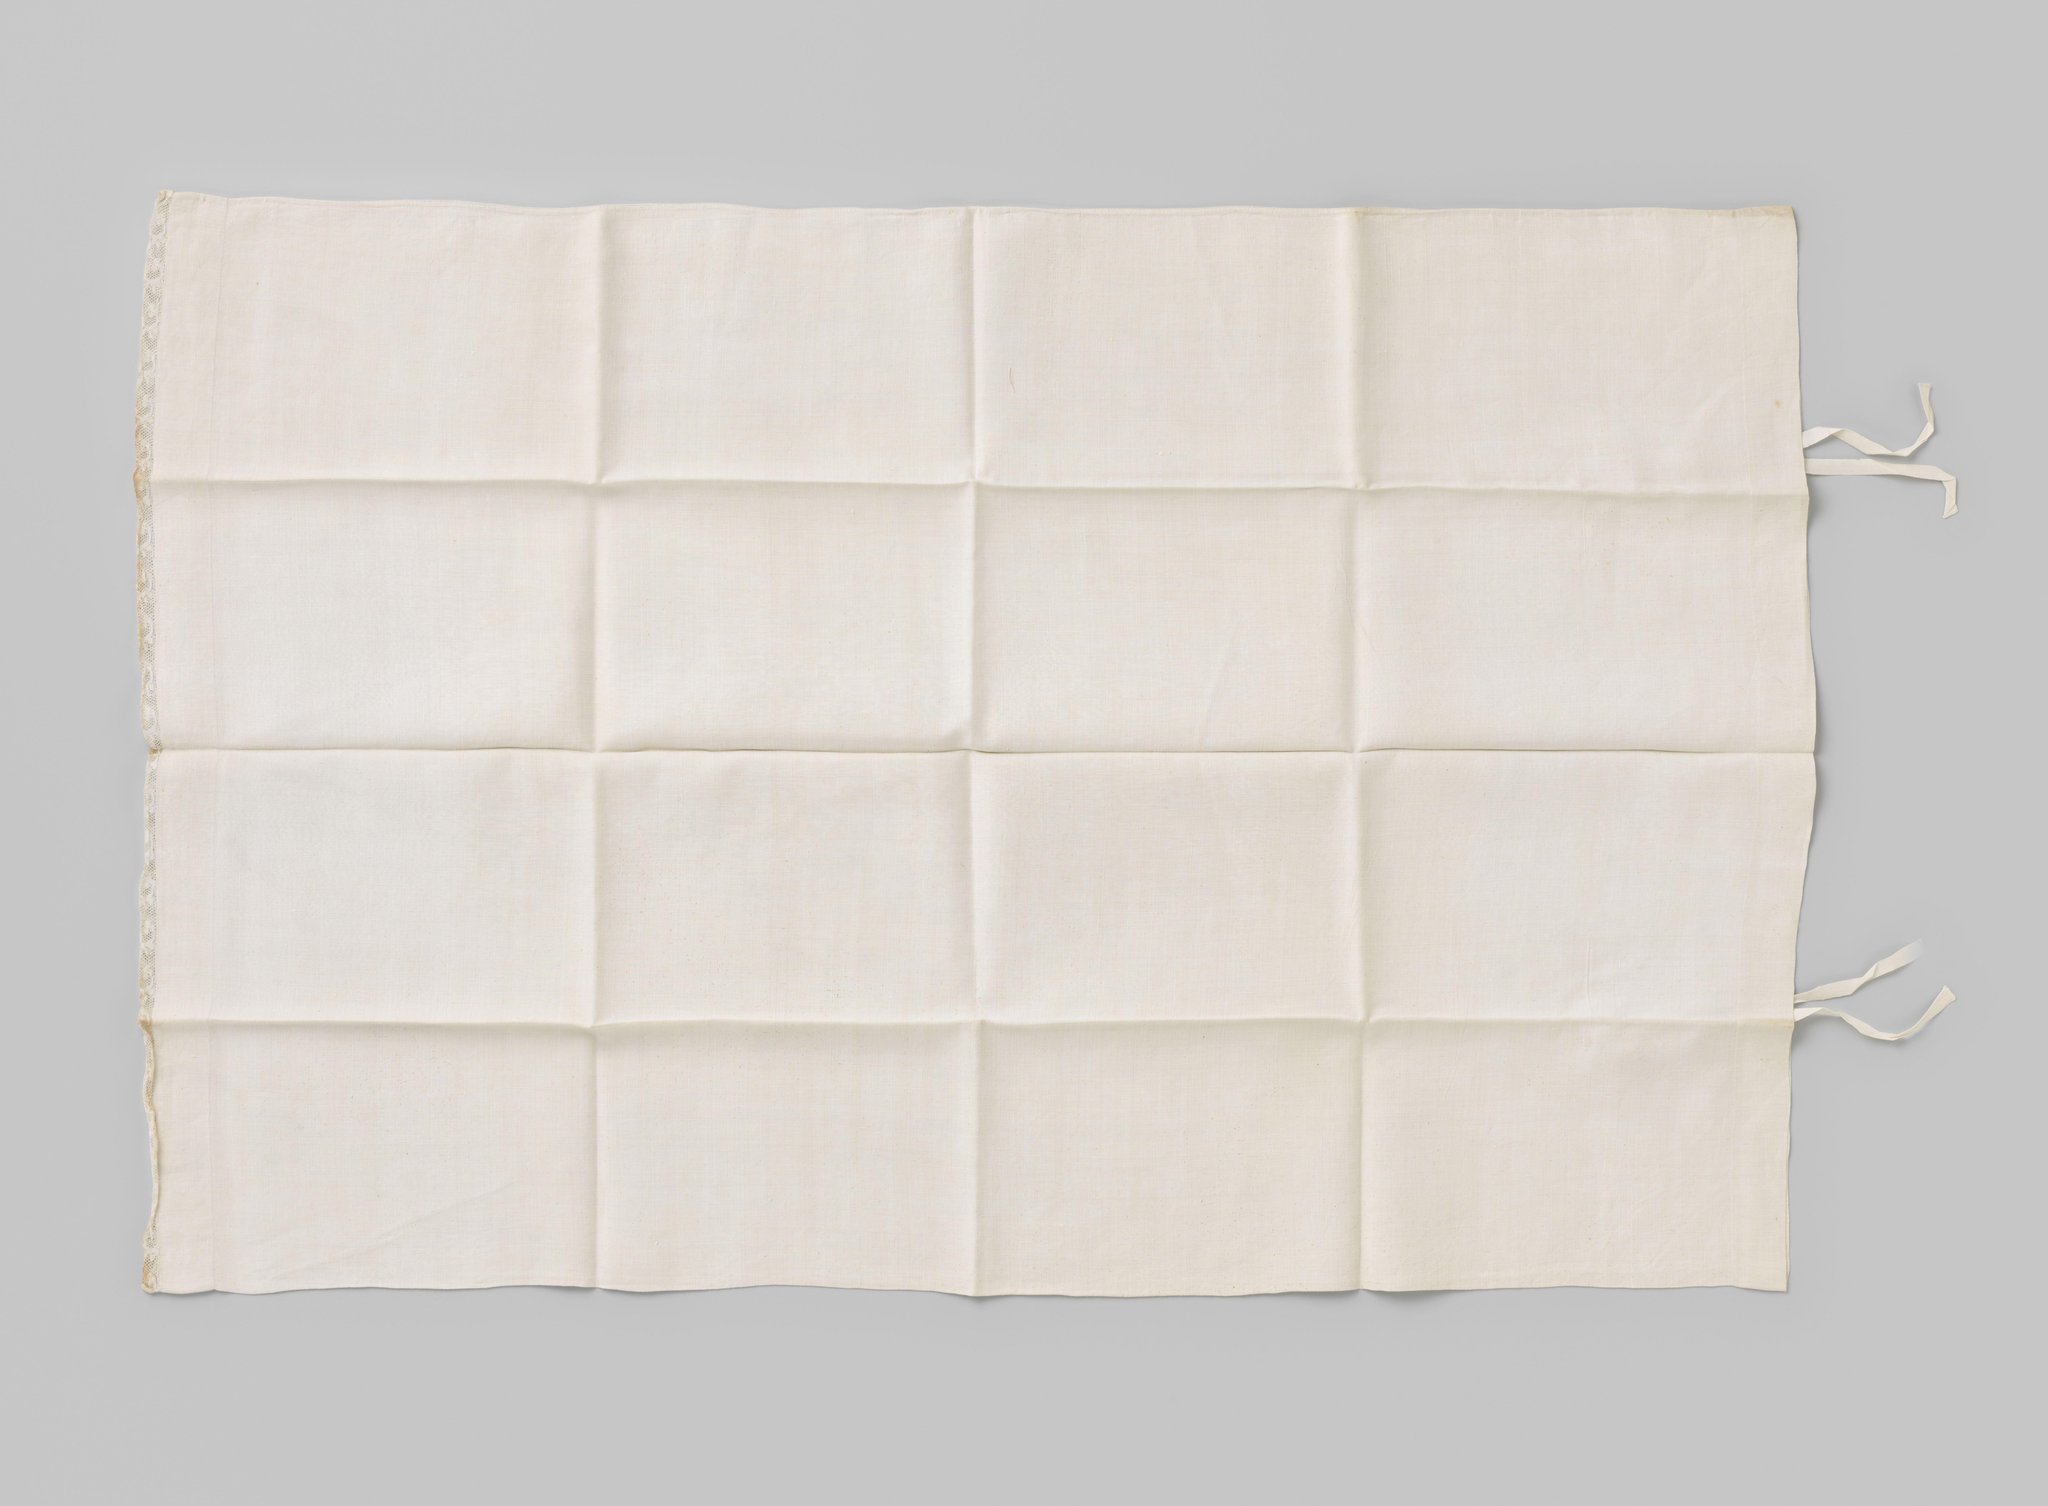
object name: sloop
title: Wit kussensloop van linnen met kanten rand, gemerkt HW 24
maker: Anonymous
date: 1600-1950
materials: linen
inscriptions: mark: ‘HW 24’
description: Wit kussensloop van linnen met kanten rand, gemerkt HW 24. Koordsluiting.